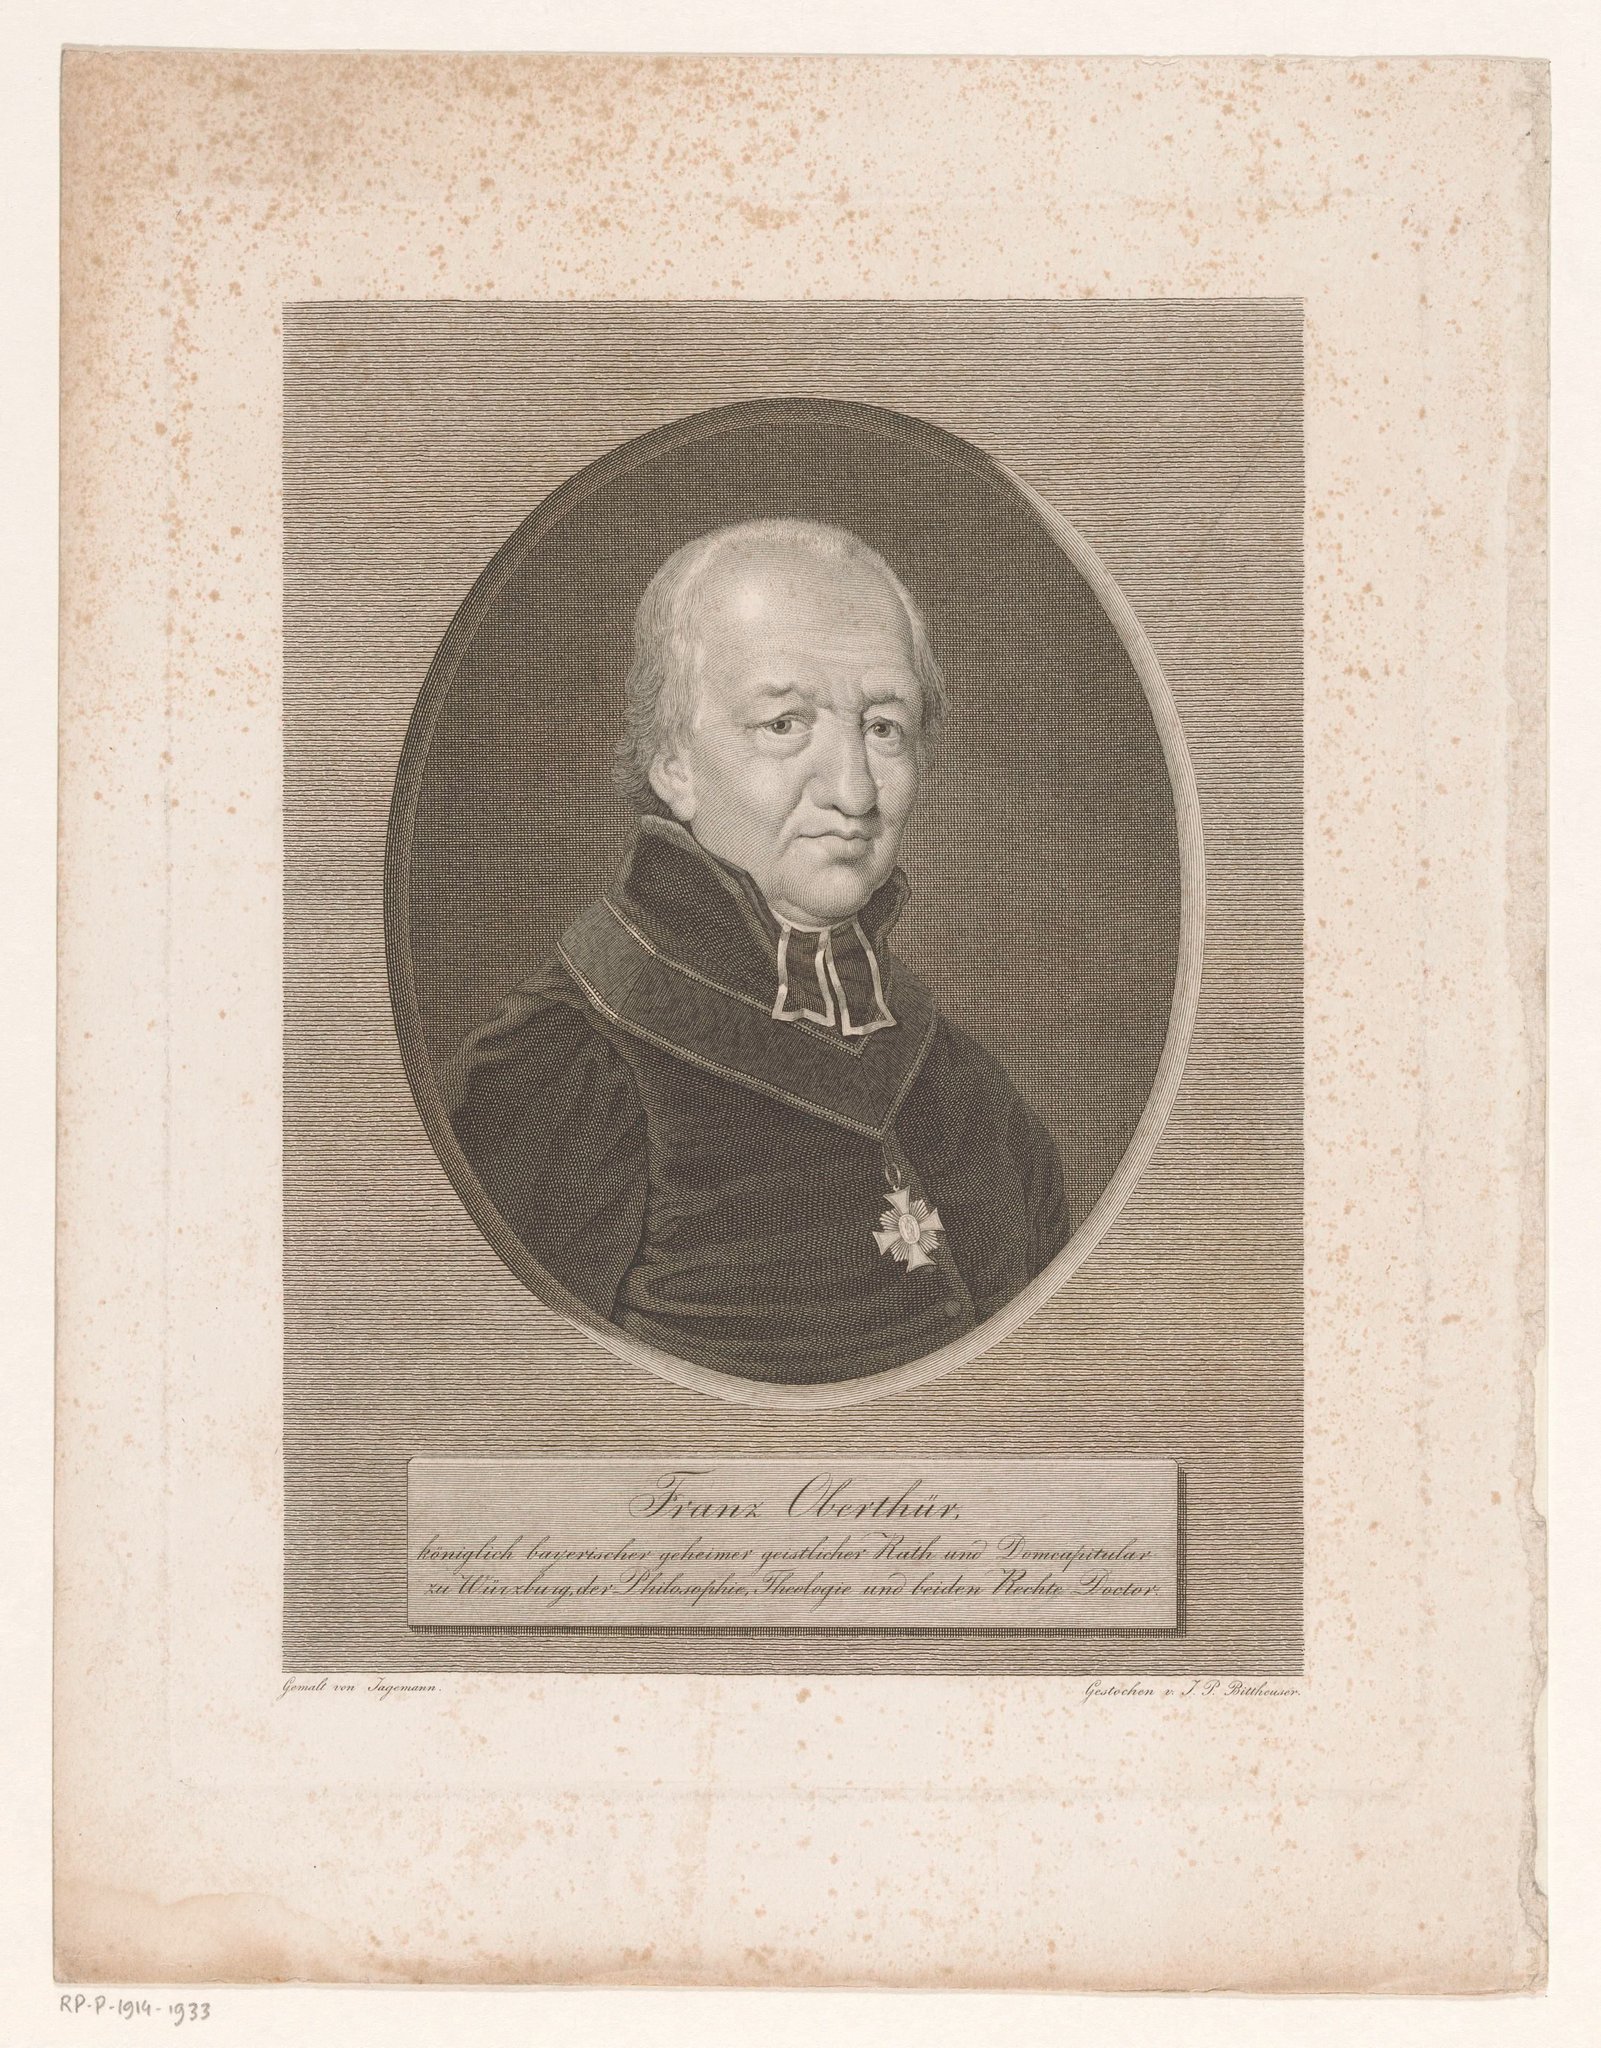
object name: print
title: Portret van Franz Oberthür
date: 1829-1859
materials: paper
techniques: engraving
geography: würzburg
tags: knighthood order, historical persons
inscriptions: collector's mark: Lugt 2228